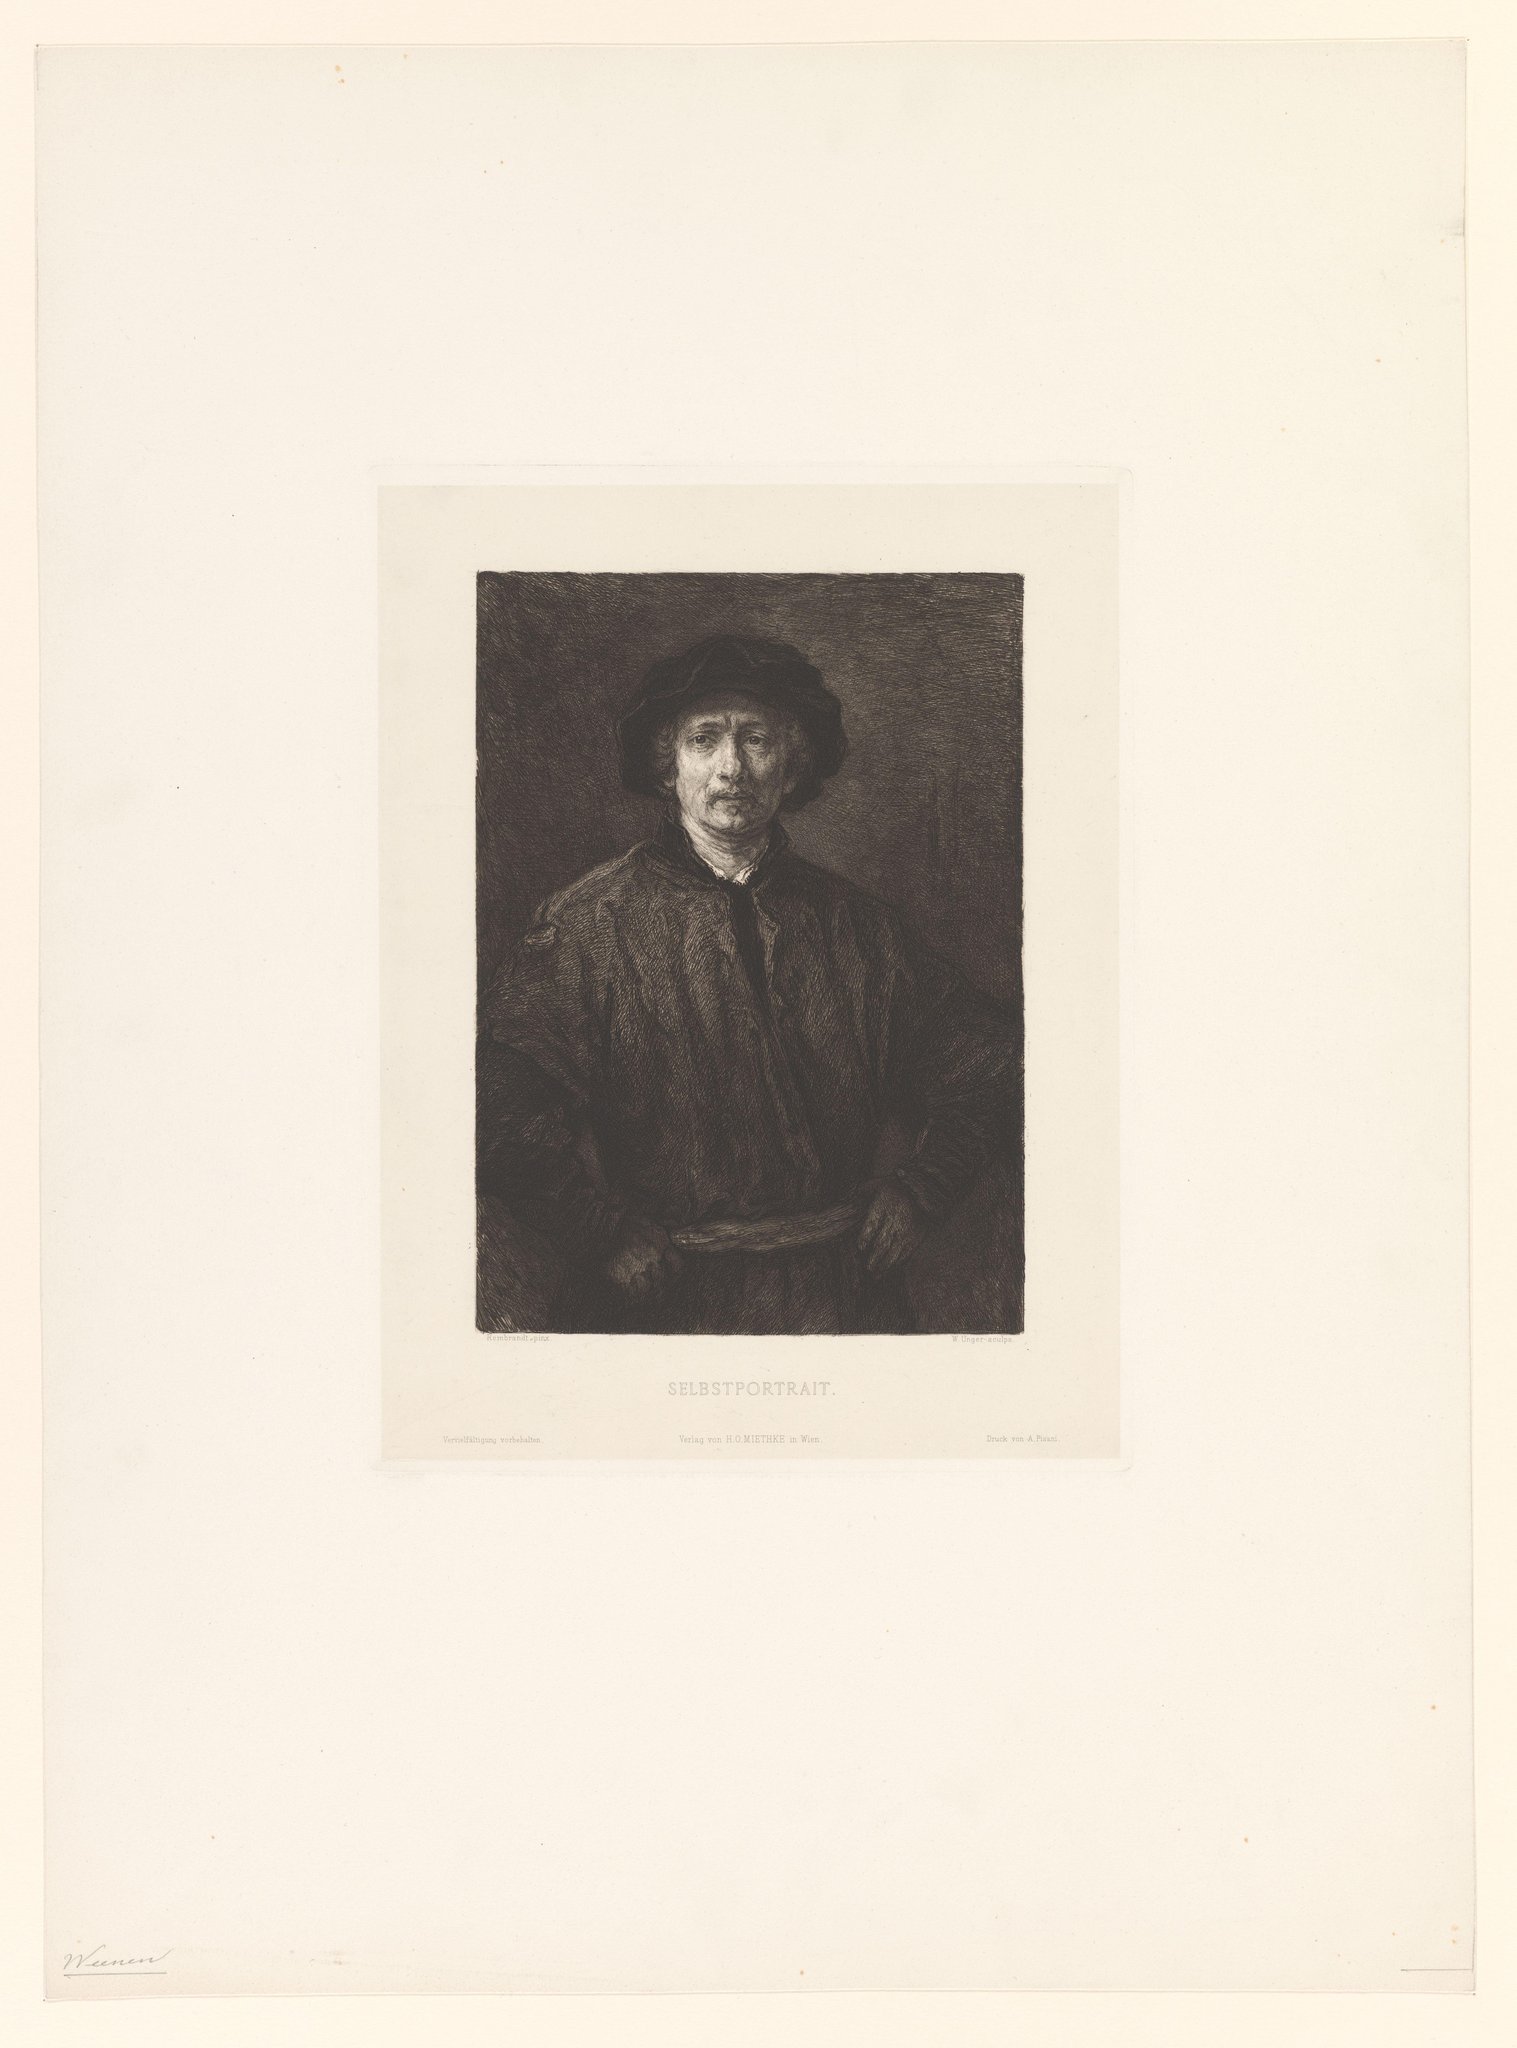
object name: print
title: Zelfportret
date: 1861-1889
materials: paper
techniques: etching, intaglio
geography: vienna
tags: leiden, amsterdam, painter, print maker, draughtsman, rembrandt van rijn, portrait, self-portrait of painter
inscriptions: collector's mark: Lugt 2228